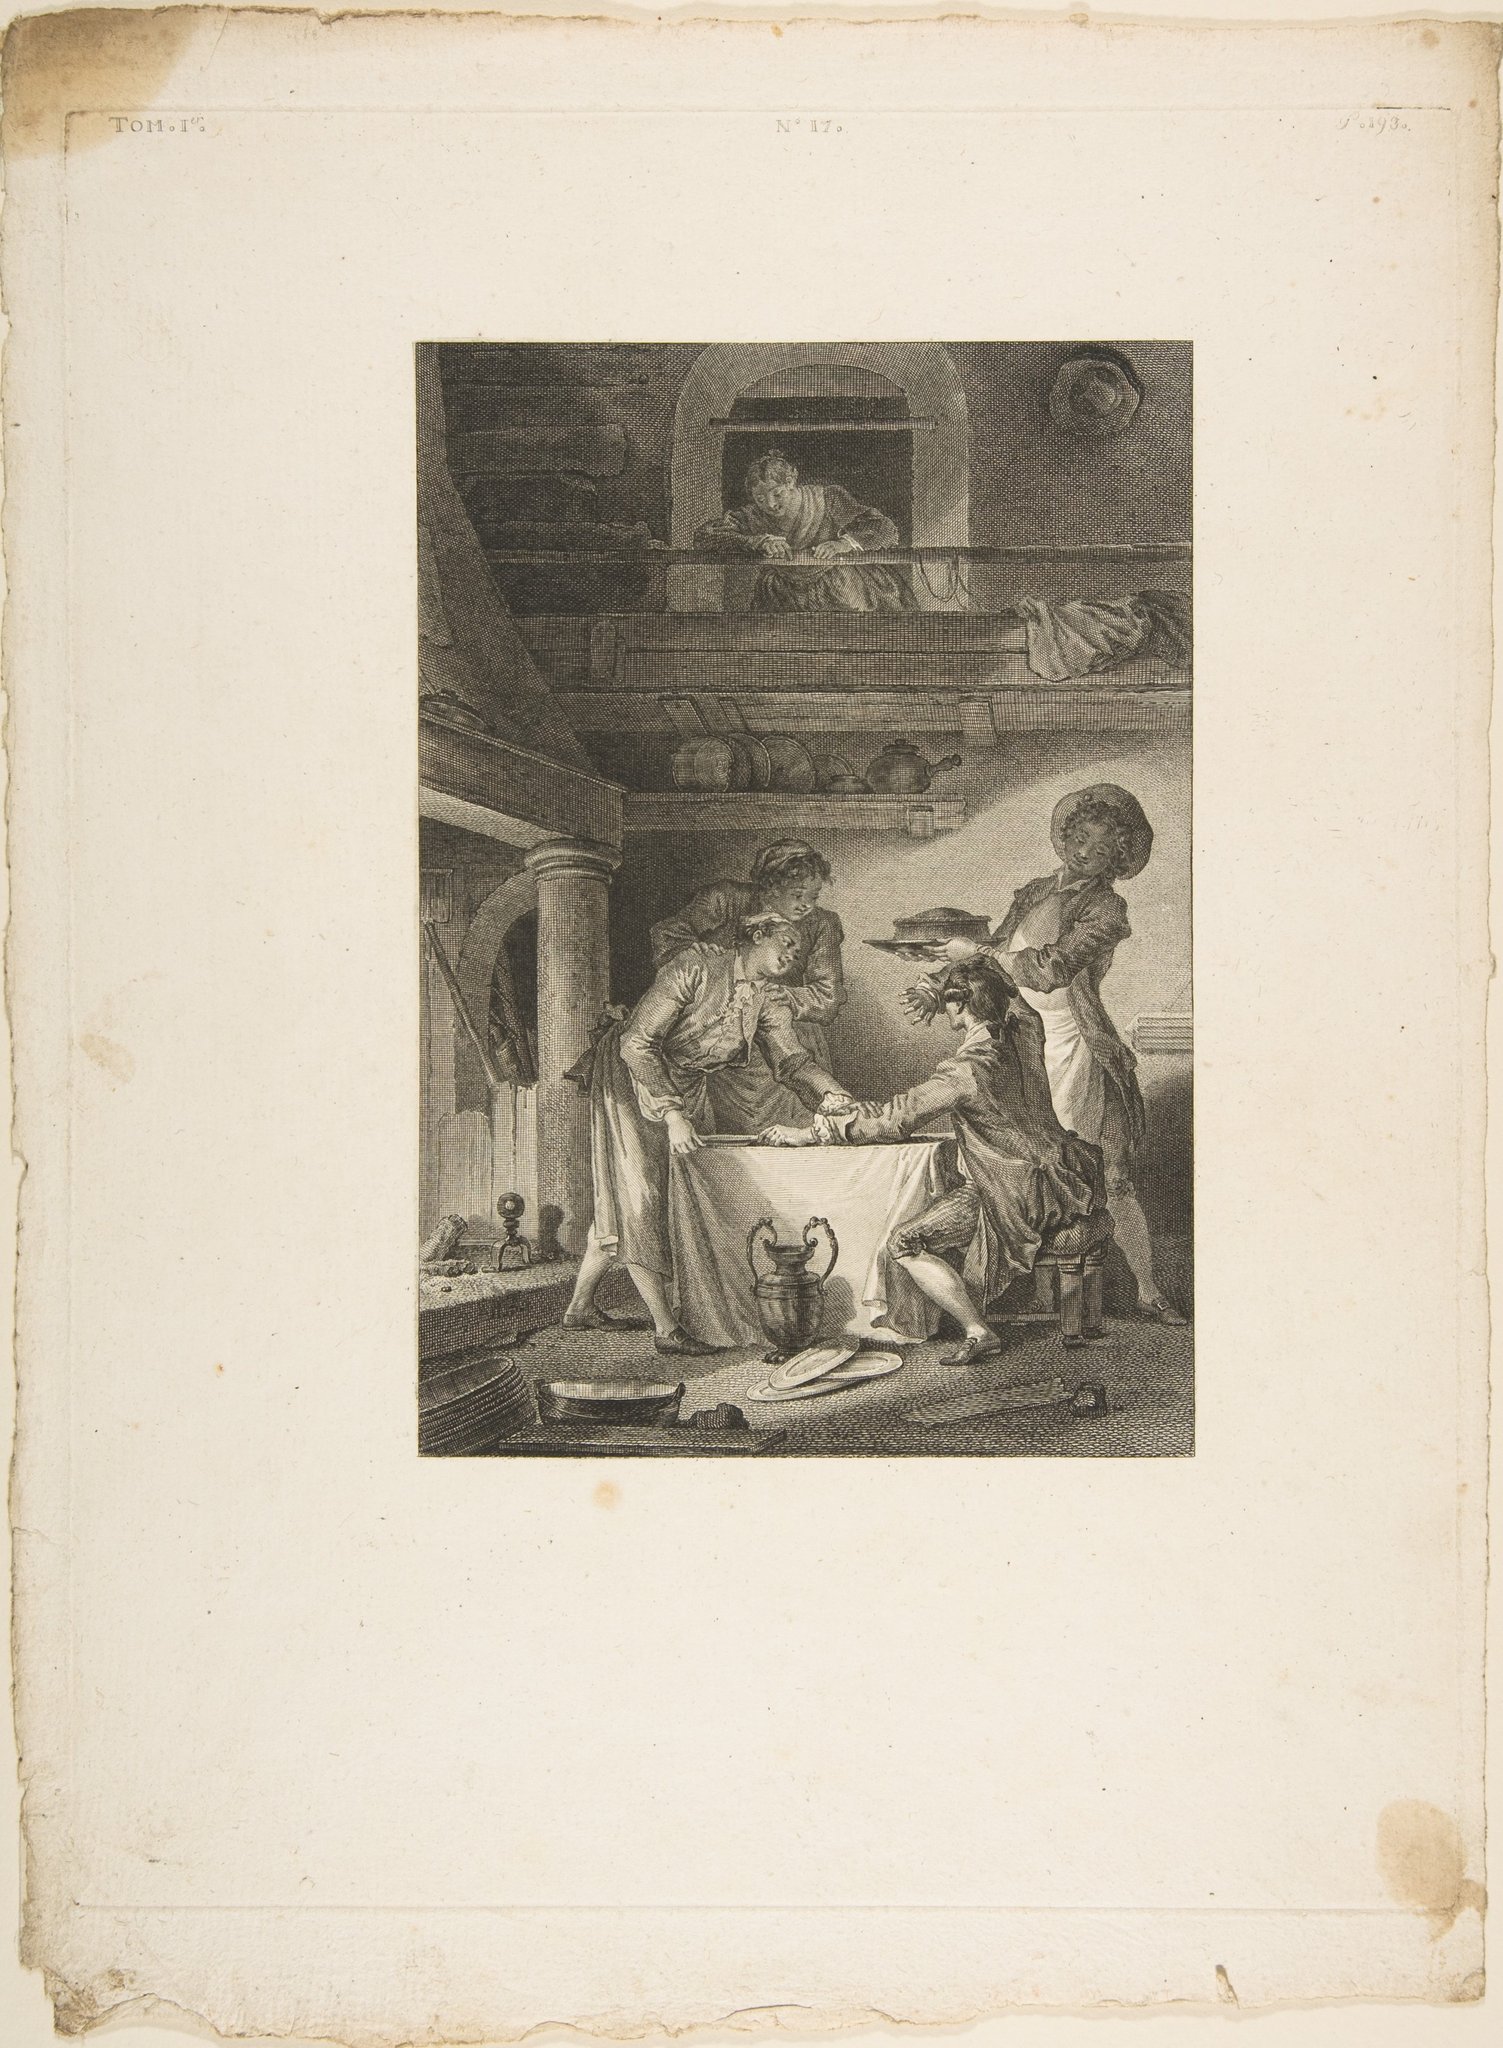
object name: print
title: Le Pate d'Anguilles, from "Contes et nouvelles en vers par Jean de La Fontaine. A Paris, de l'imprimerie de P. Didot, l'an III de la République, 1795"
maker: jean-baptiste patas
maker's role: artist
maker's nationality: french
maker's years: 1744-1802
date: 1795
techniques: engraving, etching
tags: men,women,dining